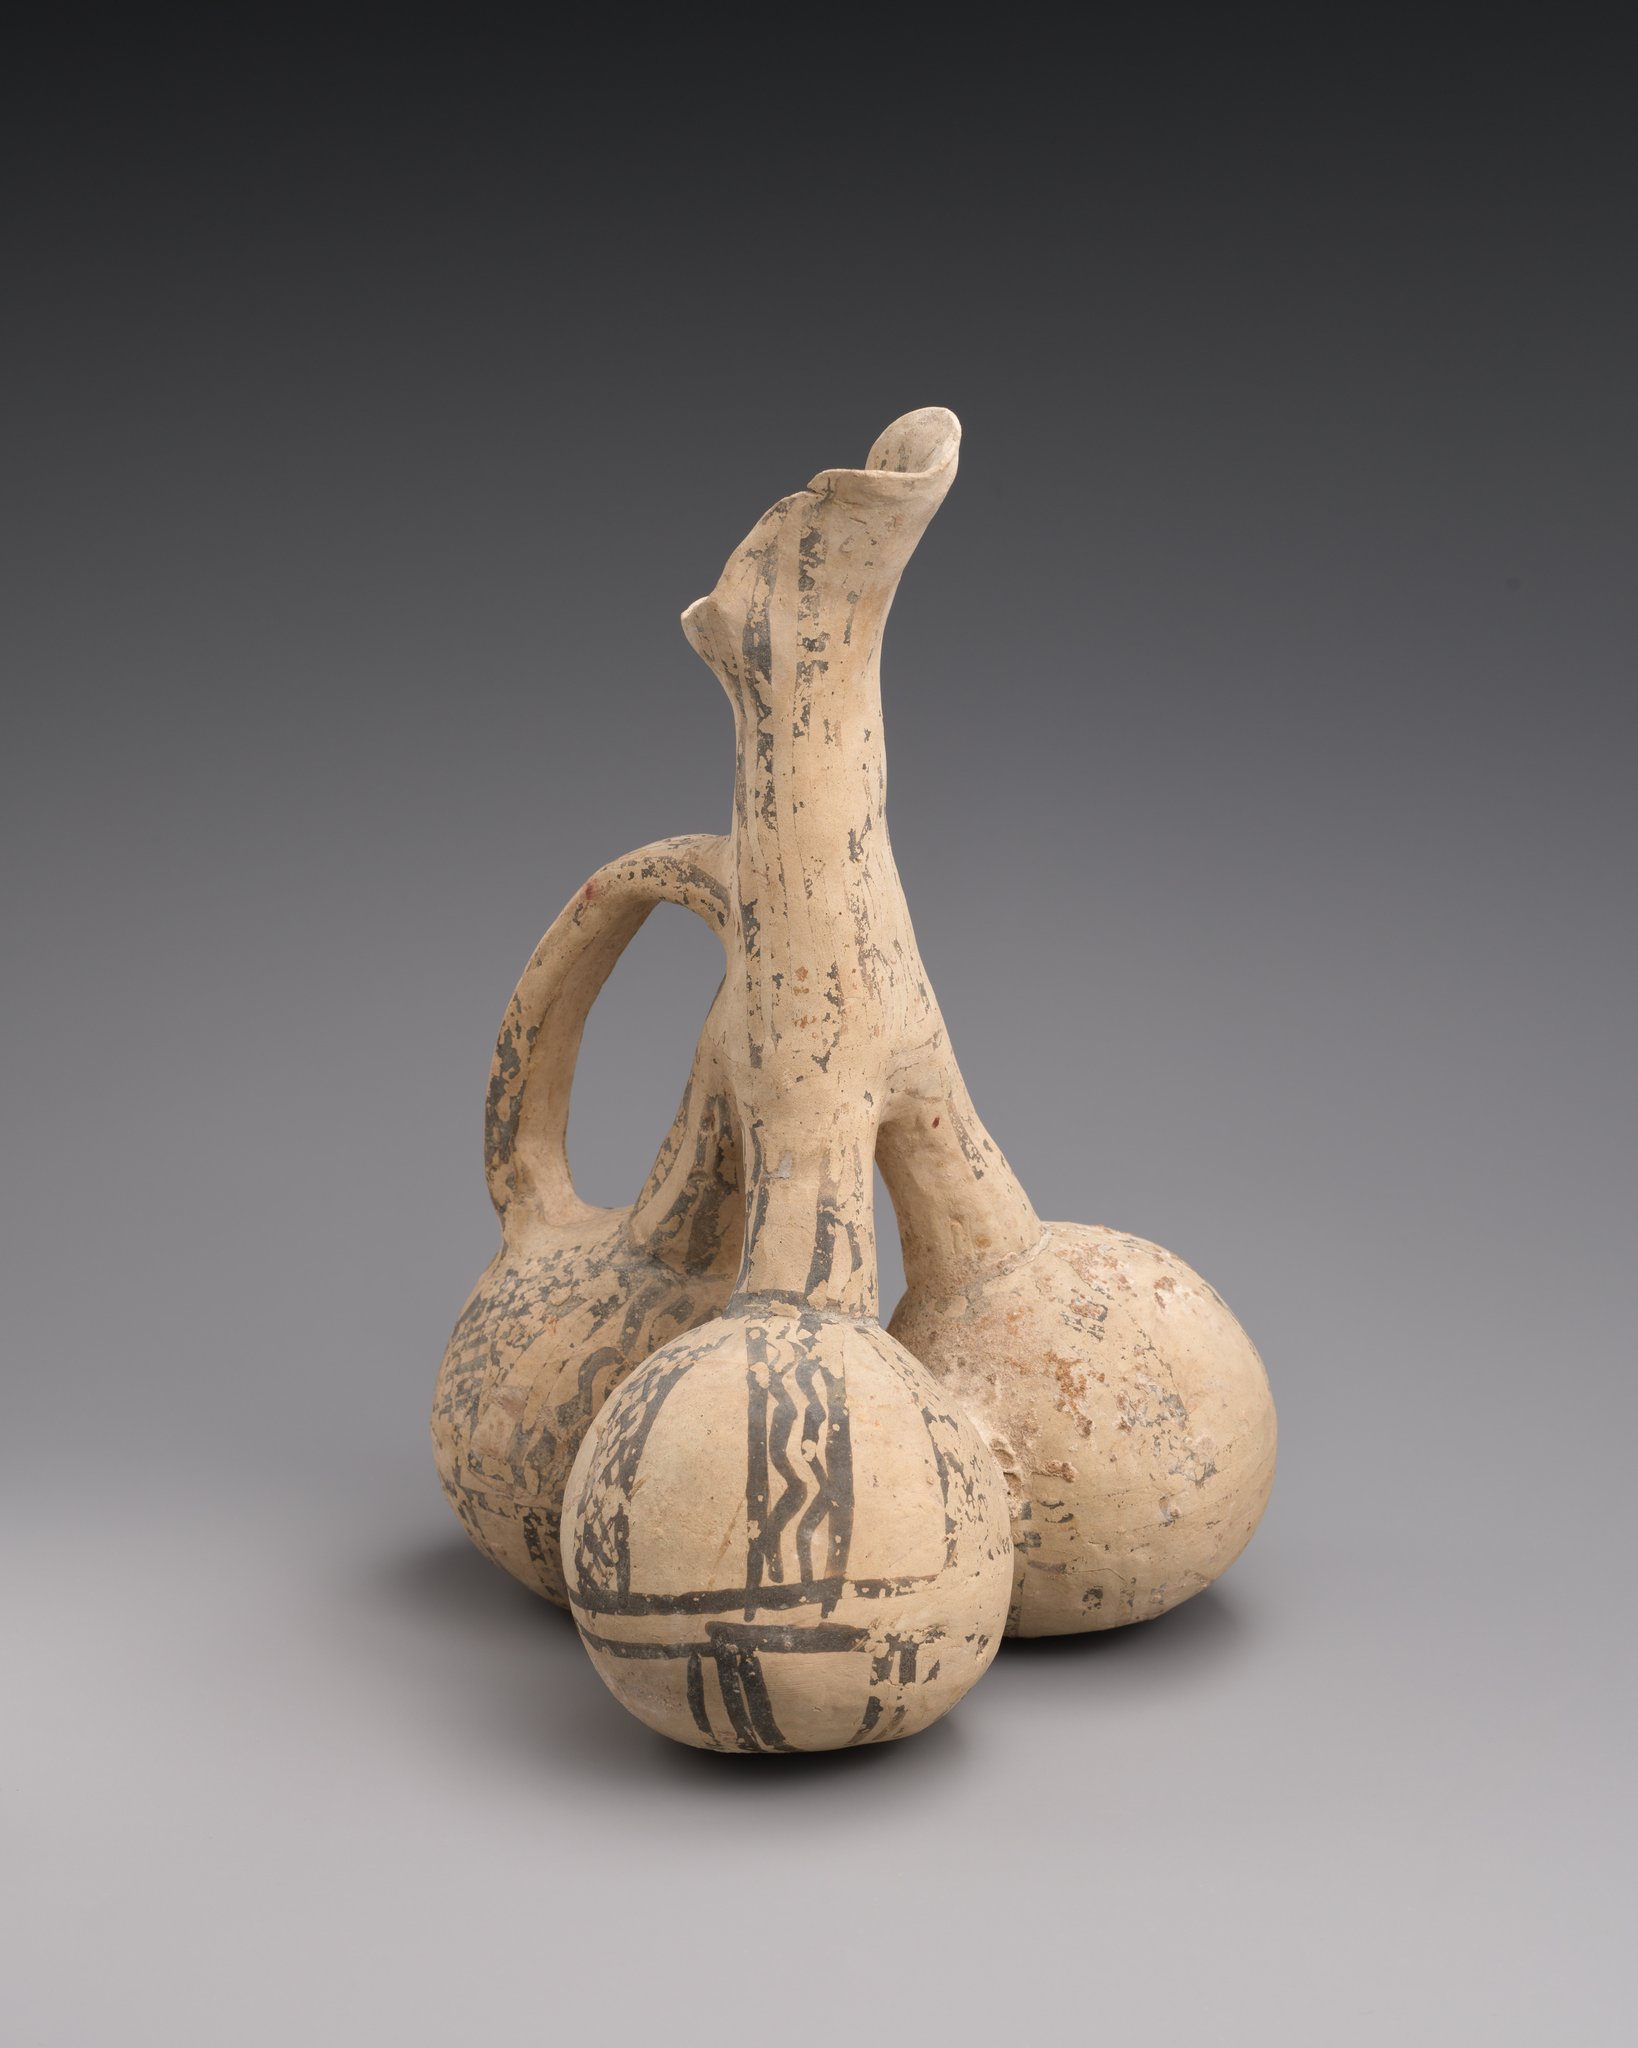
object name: composite jug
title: Terracotta composite jug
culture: cypriot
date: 1900-1600 BCE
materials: terracotta